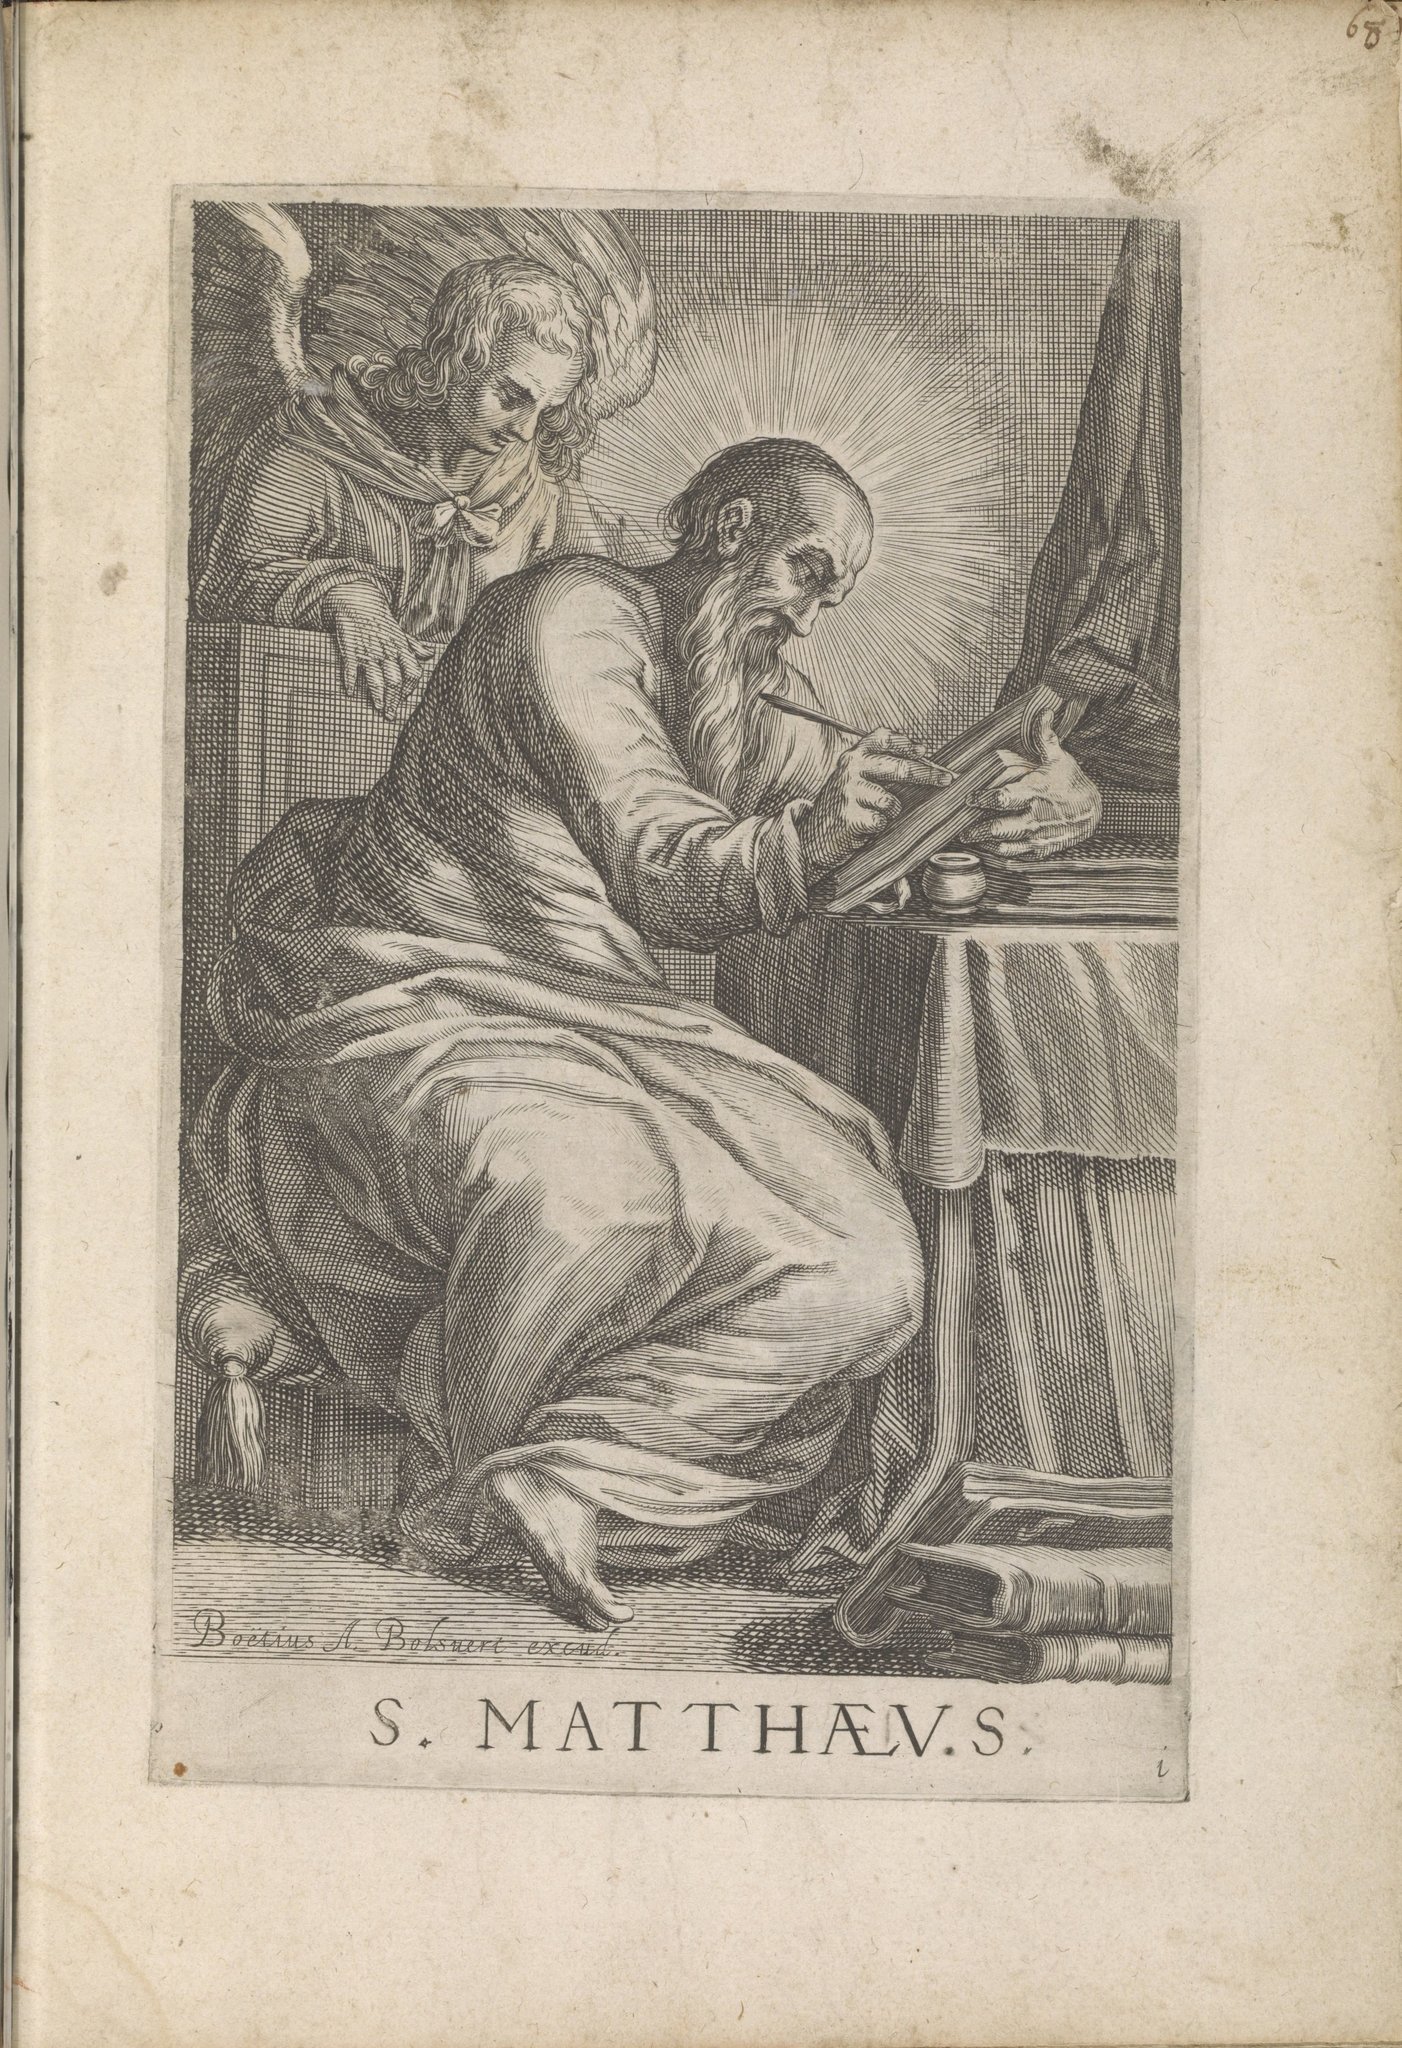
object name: print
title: Evangelist Matteüs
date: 1609-1633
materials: paper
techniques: engraving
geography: low countries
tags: st. matthew writing the gospel, usually the angel present, dictating or assisting him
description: De evangelist Matteüs schrijft zijn evangelie. Achter hem staat de engel. Rechtsonder: i. Prent maakt deel uit van een album.